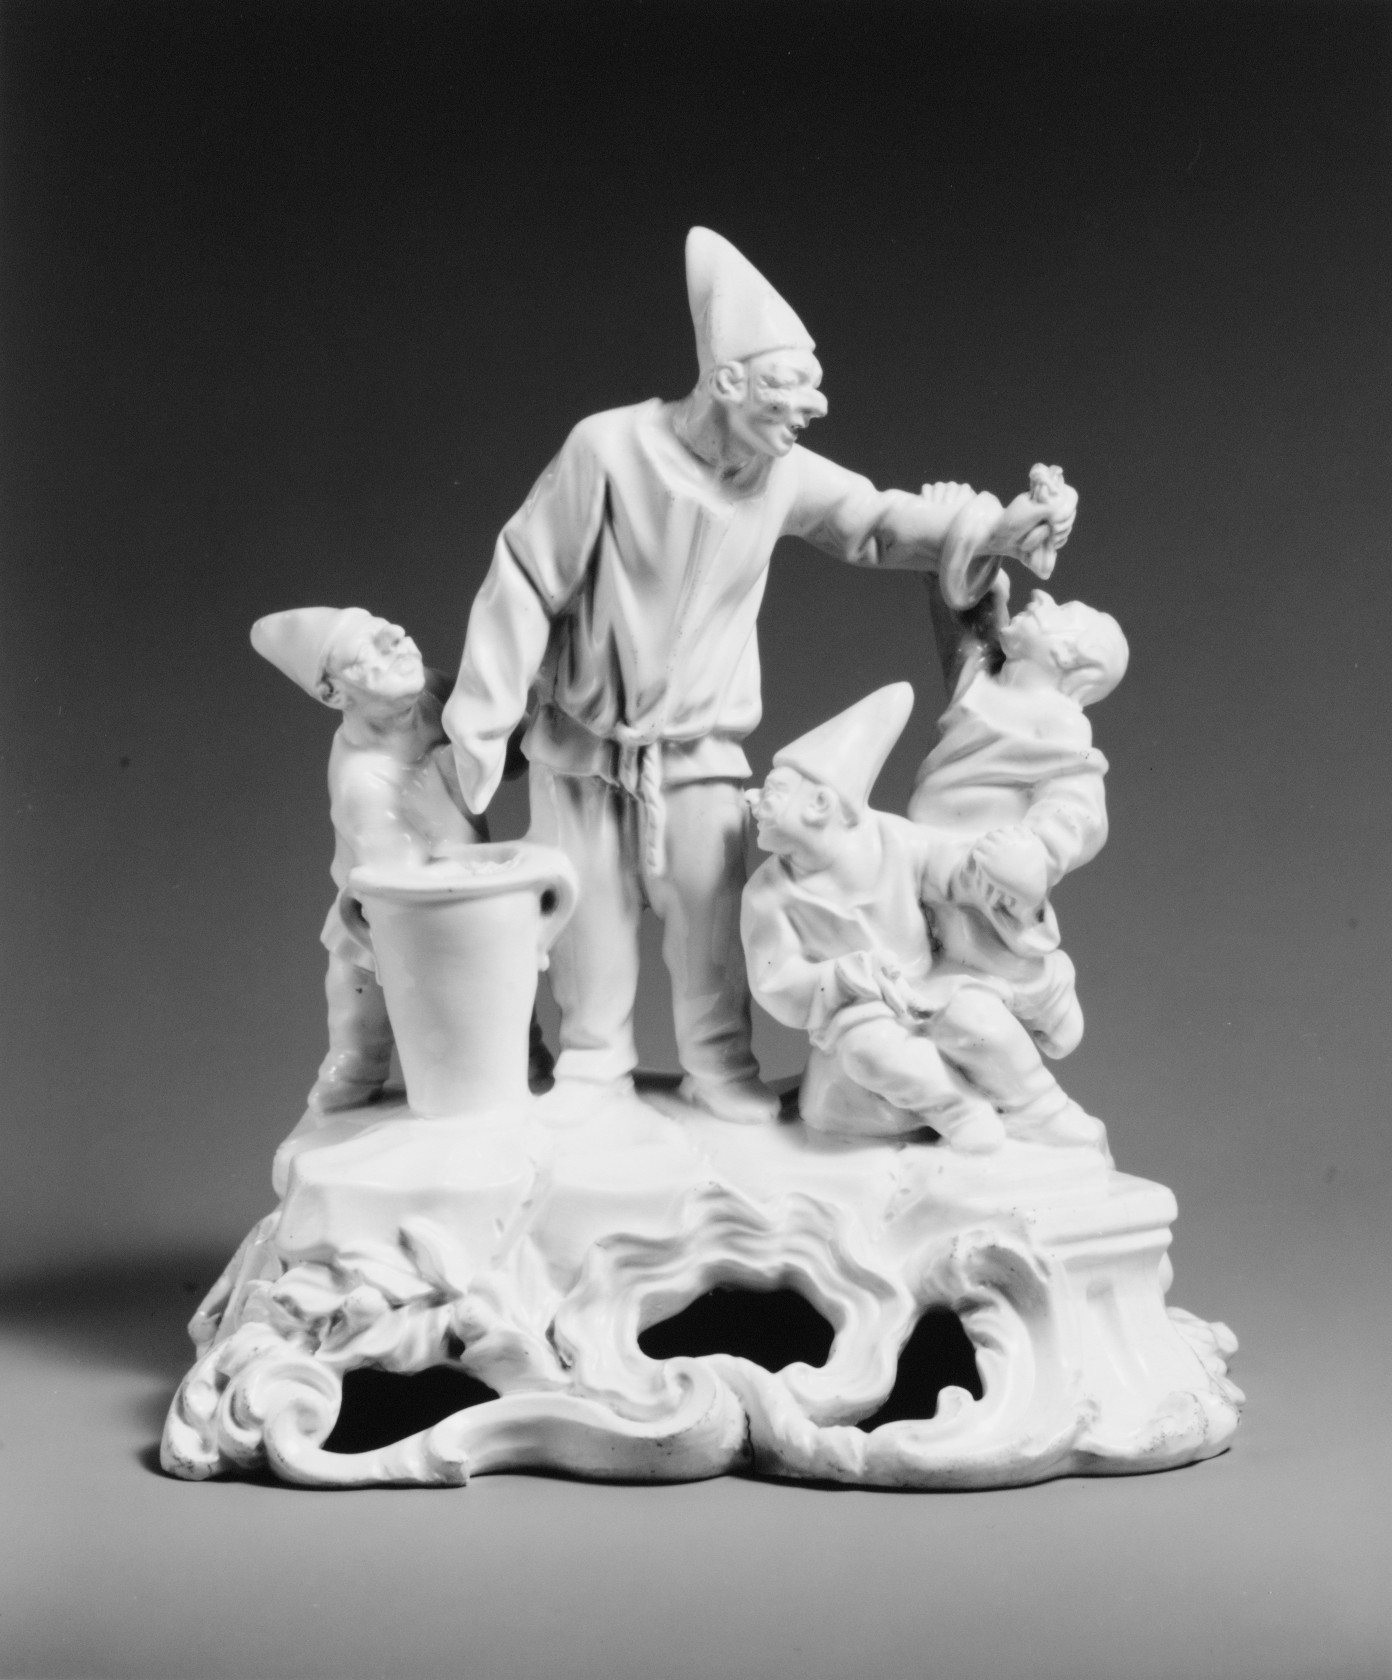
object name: group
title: Spaghetti Eaters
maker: real fabrica de buen retiro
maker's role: factory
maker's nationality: spanish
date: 1760-1765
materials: soft paste porcelain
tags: men